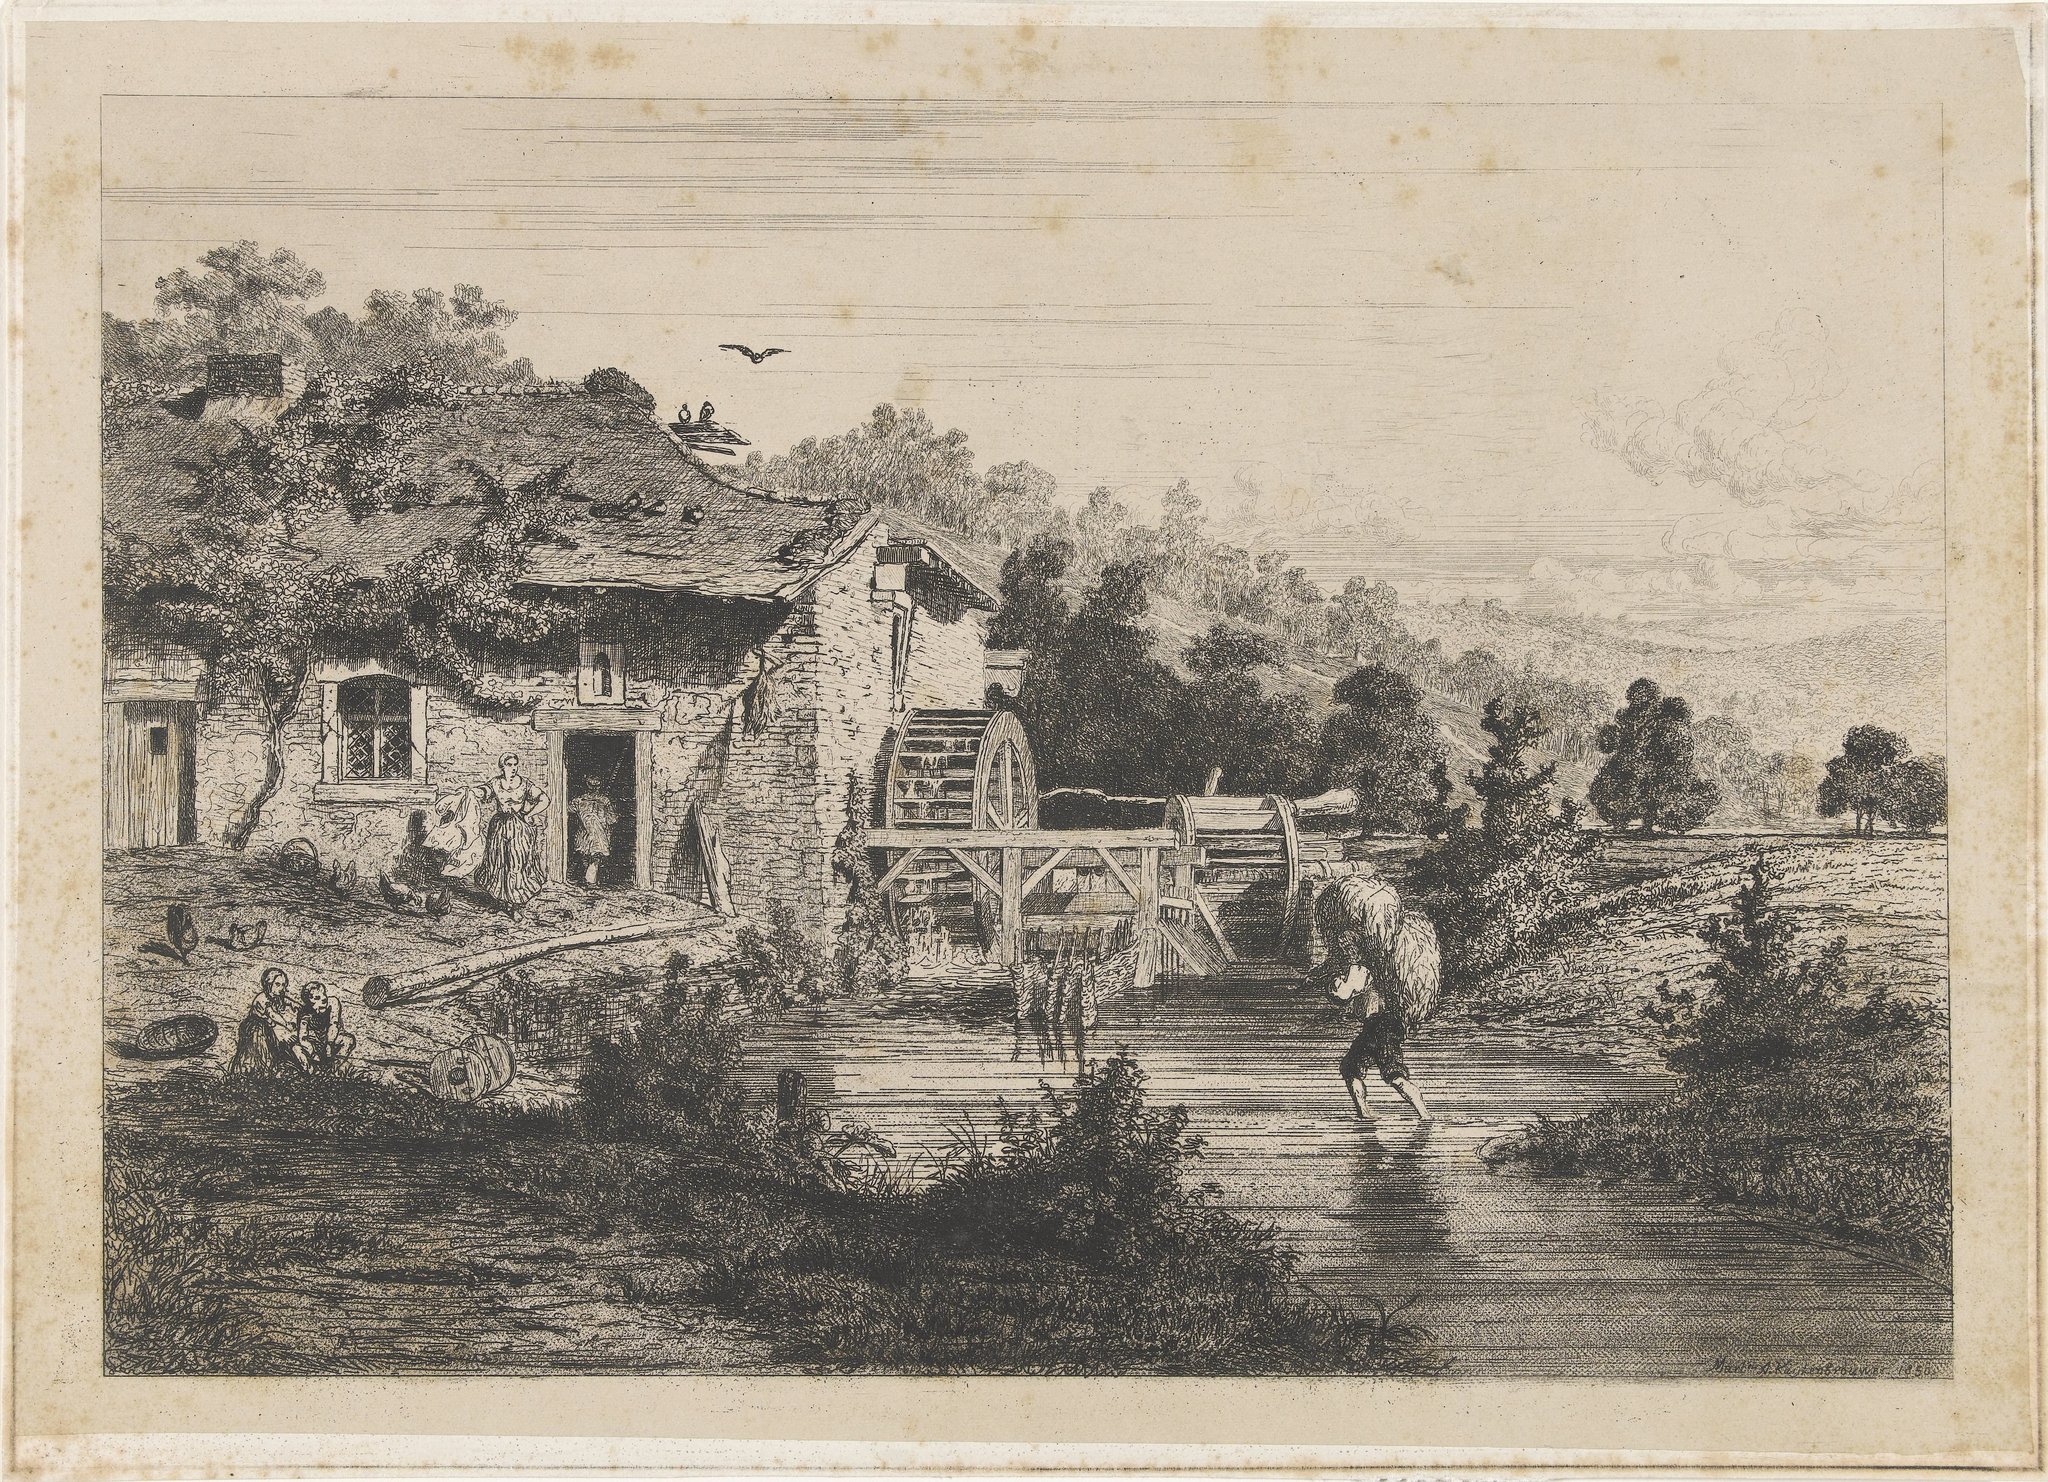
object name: print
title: Watermolen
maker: martinus antonius kuytenbrouwer jr.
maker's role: draughtsman, painter, print maker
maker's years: 1821-1897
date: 1850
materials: paper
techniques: etching, roulette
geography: brussels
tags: agricultural products and by-products: hay, farmers - aa - female farmer, farmer's wife, brook, fowl (cock, hen, chicken, etc.), watermill in landscape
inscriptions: collector's mark: Lugt 2228, collector's mark: Lugt 1485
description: Landschap met een watermolen aan een beek. In de beek loopt een man met een baal hooi op zijn rug. Op het erf voor de molen staat een boerin en lopen een paar kippen. Aan de waterkant twee spelende kinderen.